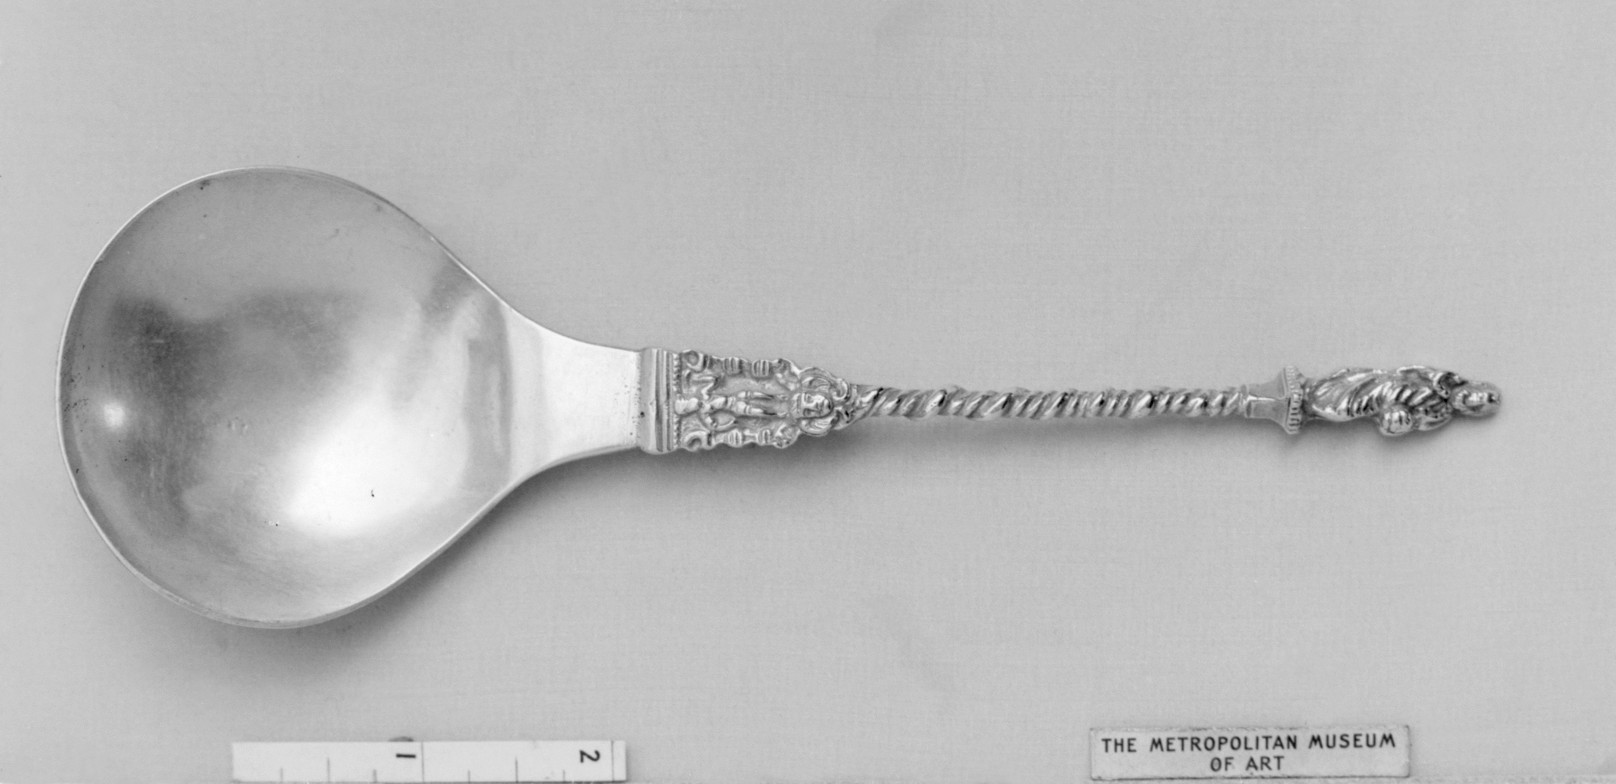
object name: apostle spoon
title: St. Philip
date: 1851-1900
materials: silver